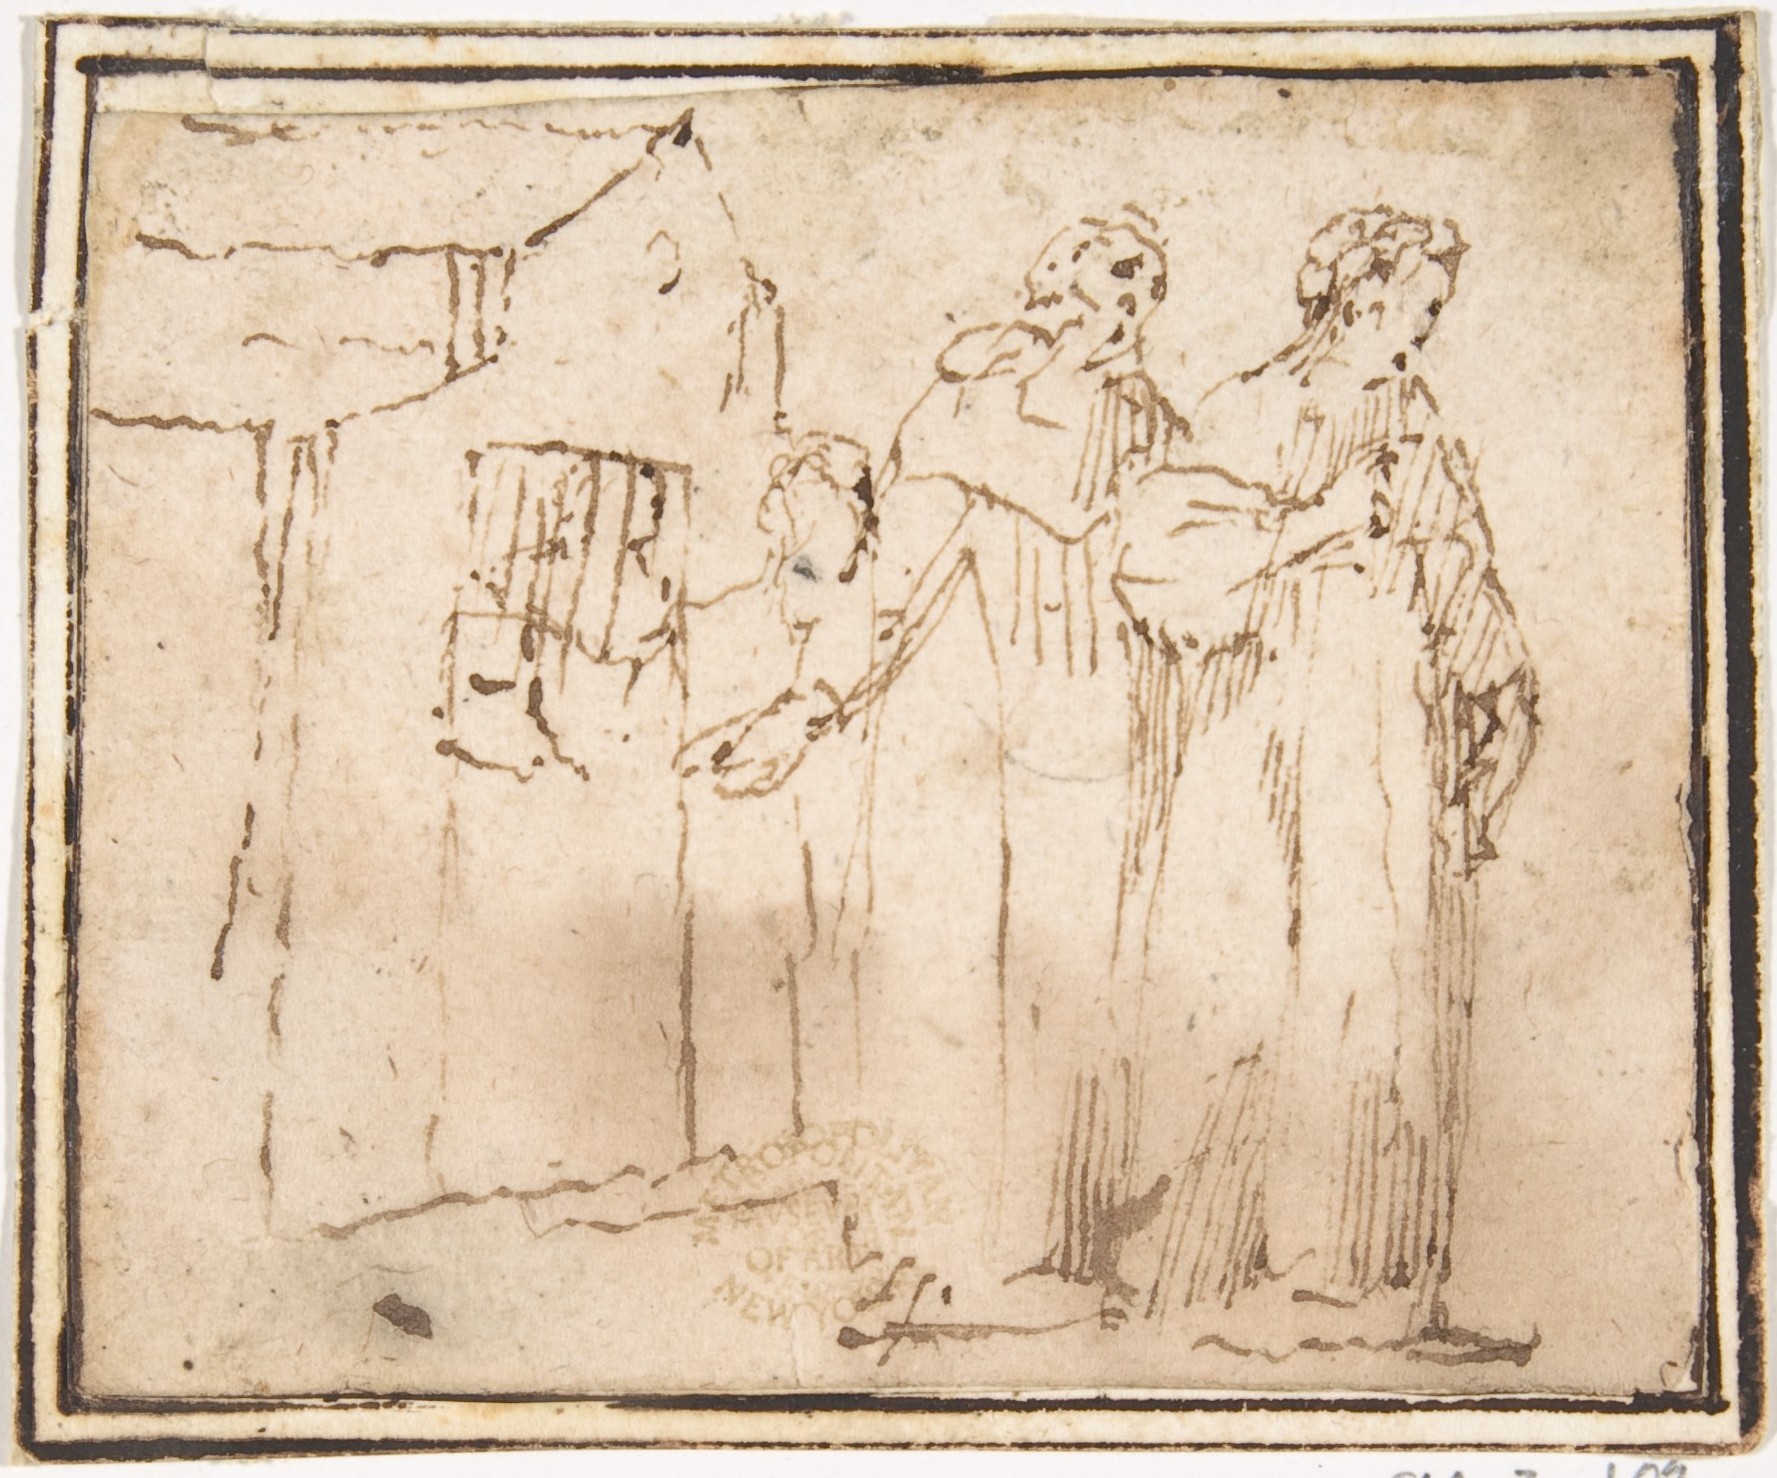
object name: drawing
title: Two Monastic Figures Standing before a Church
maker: francesco allegrini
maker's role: artist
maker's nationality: italian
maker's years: 1615-1679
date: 1624-1663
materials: ink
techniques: pen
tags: human figures,churches